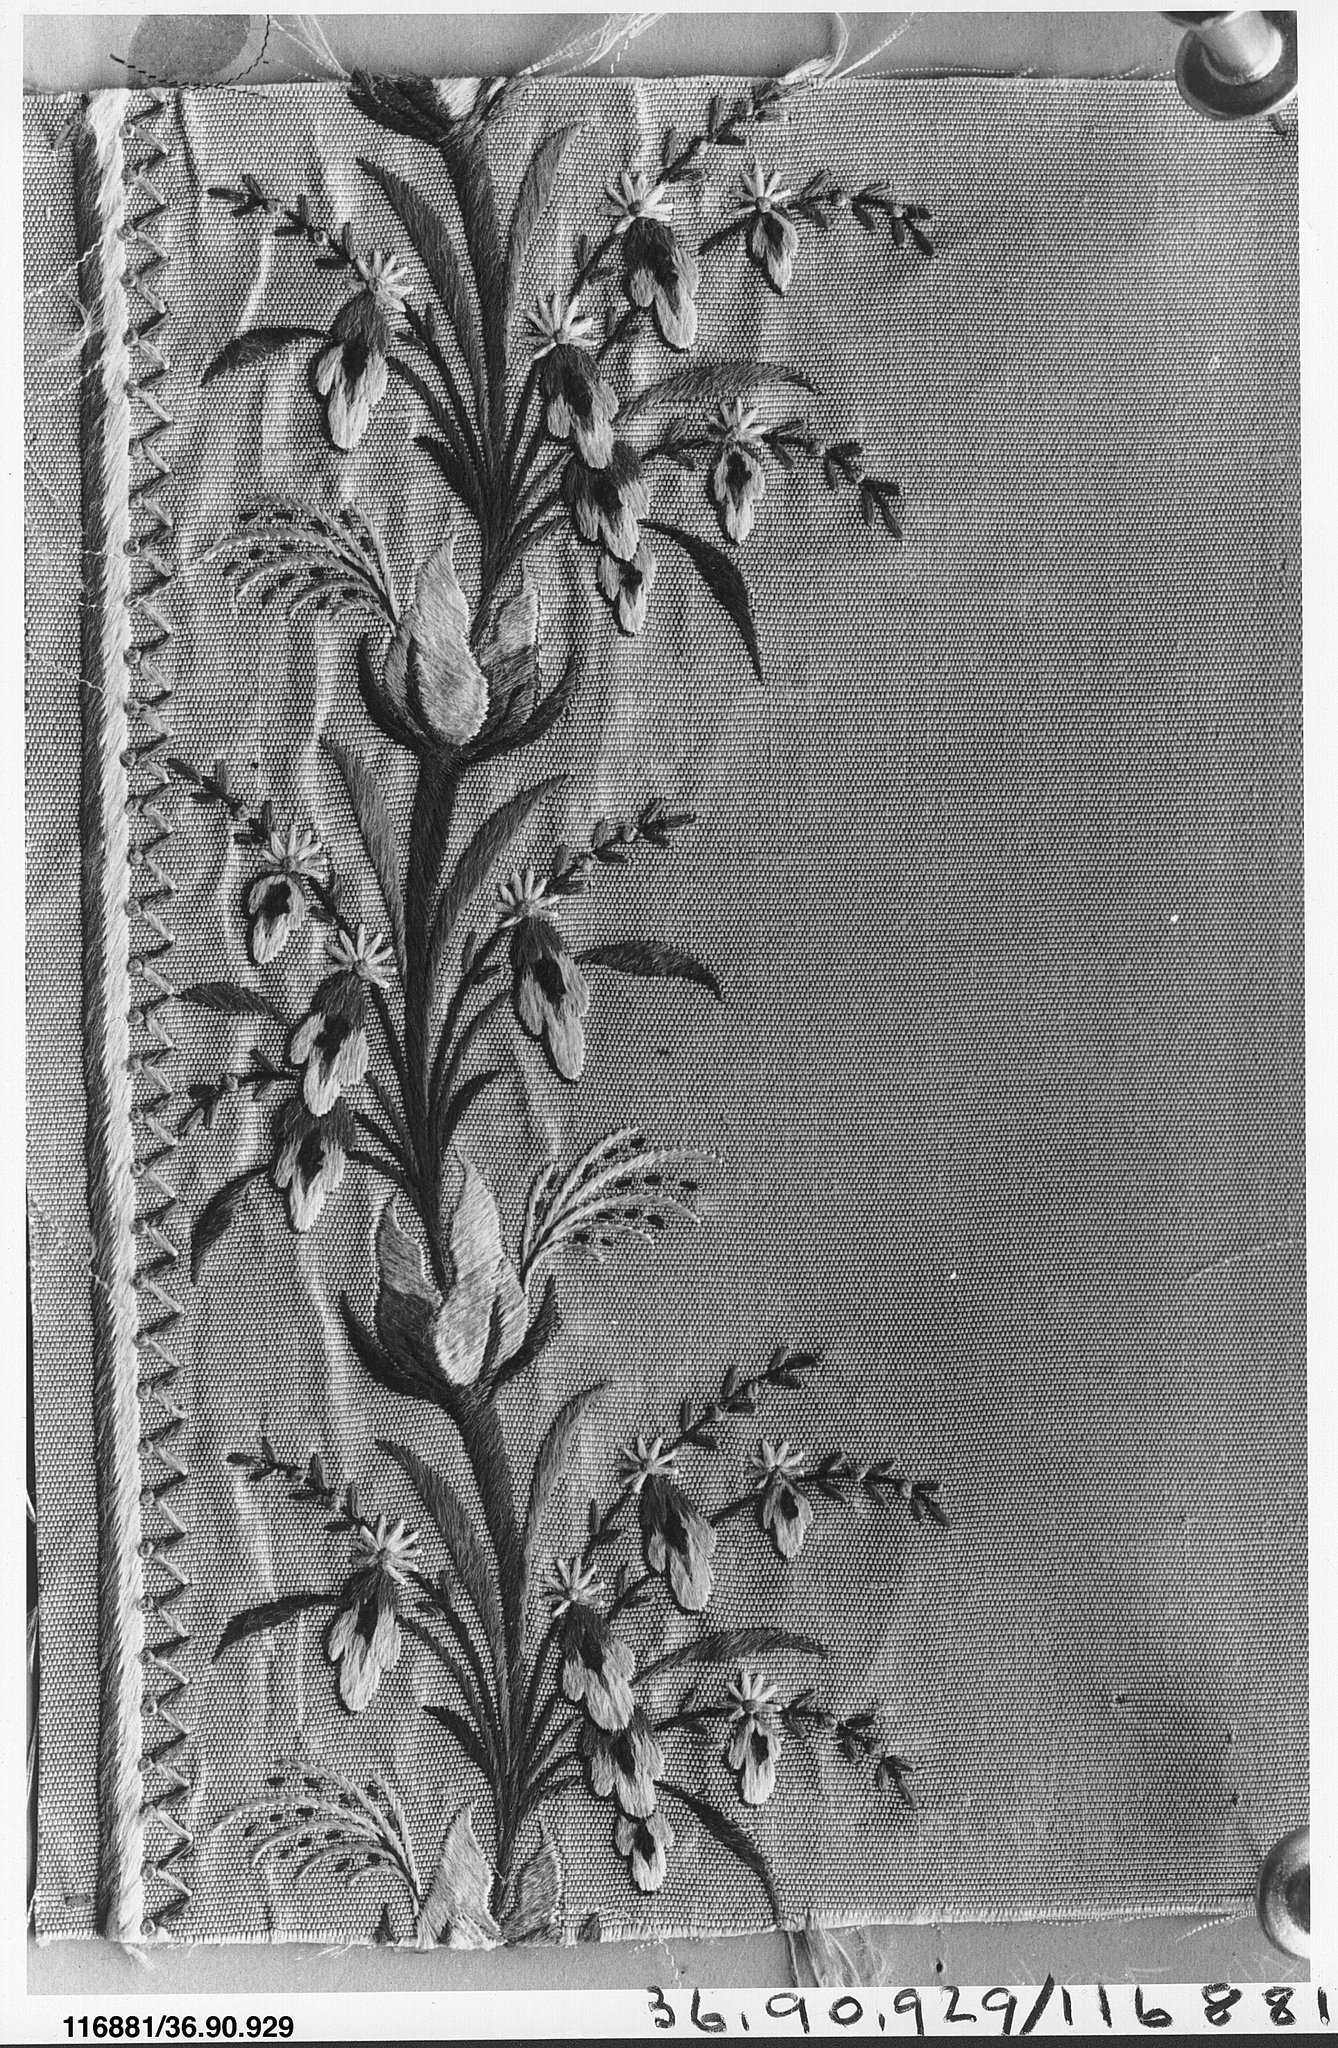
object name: sample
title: Embroidery sample for a man’s suit or waistcoat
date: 1785-1815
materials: silk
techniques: embroidery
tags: flowers